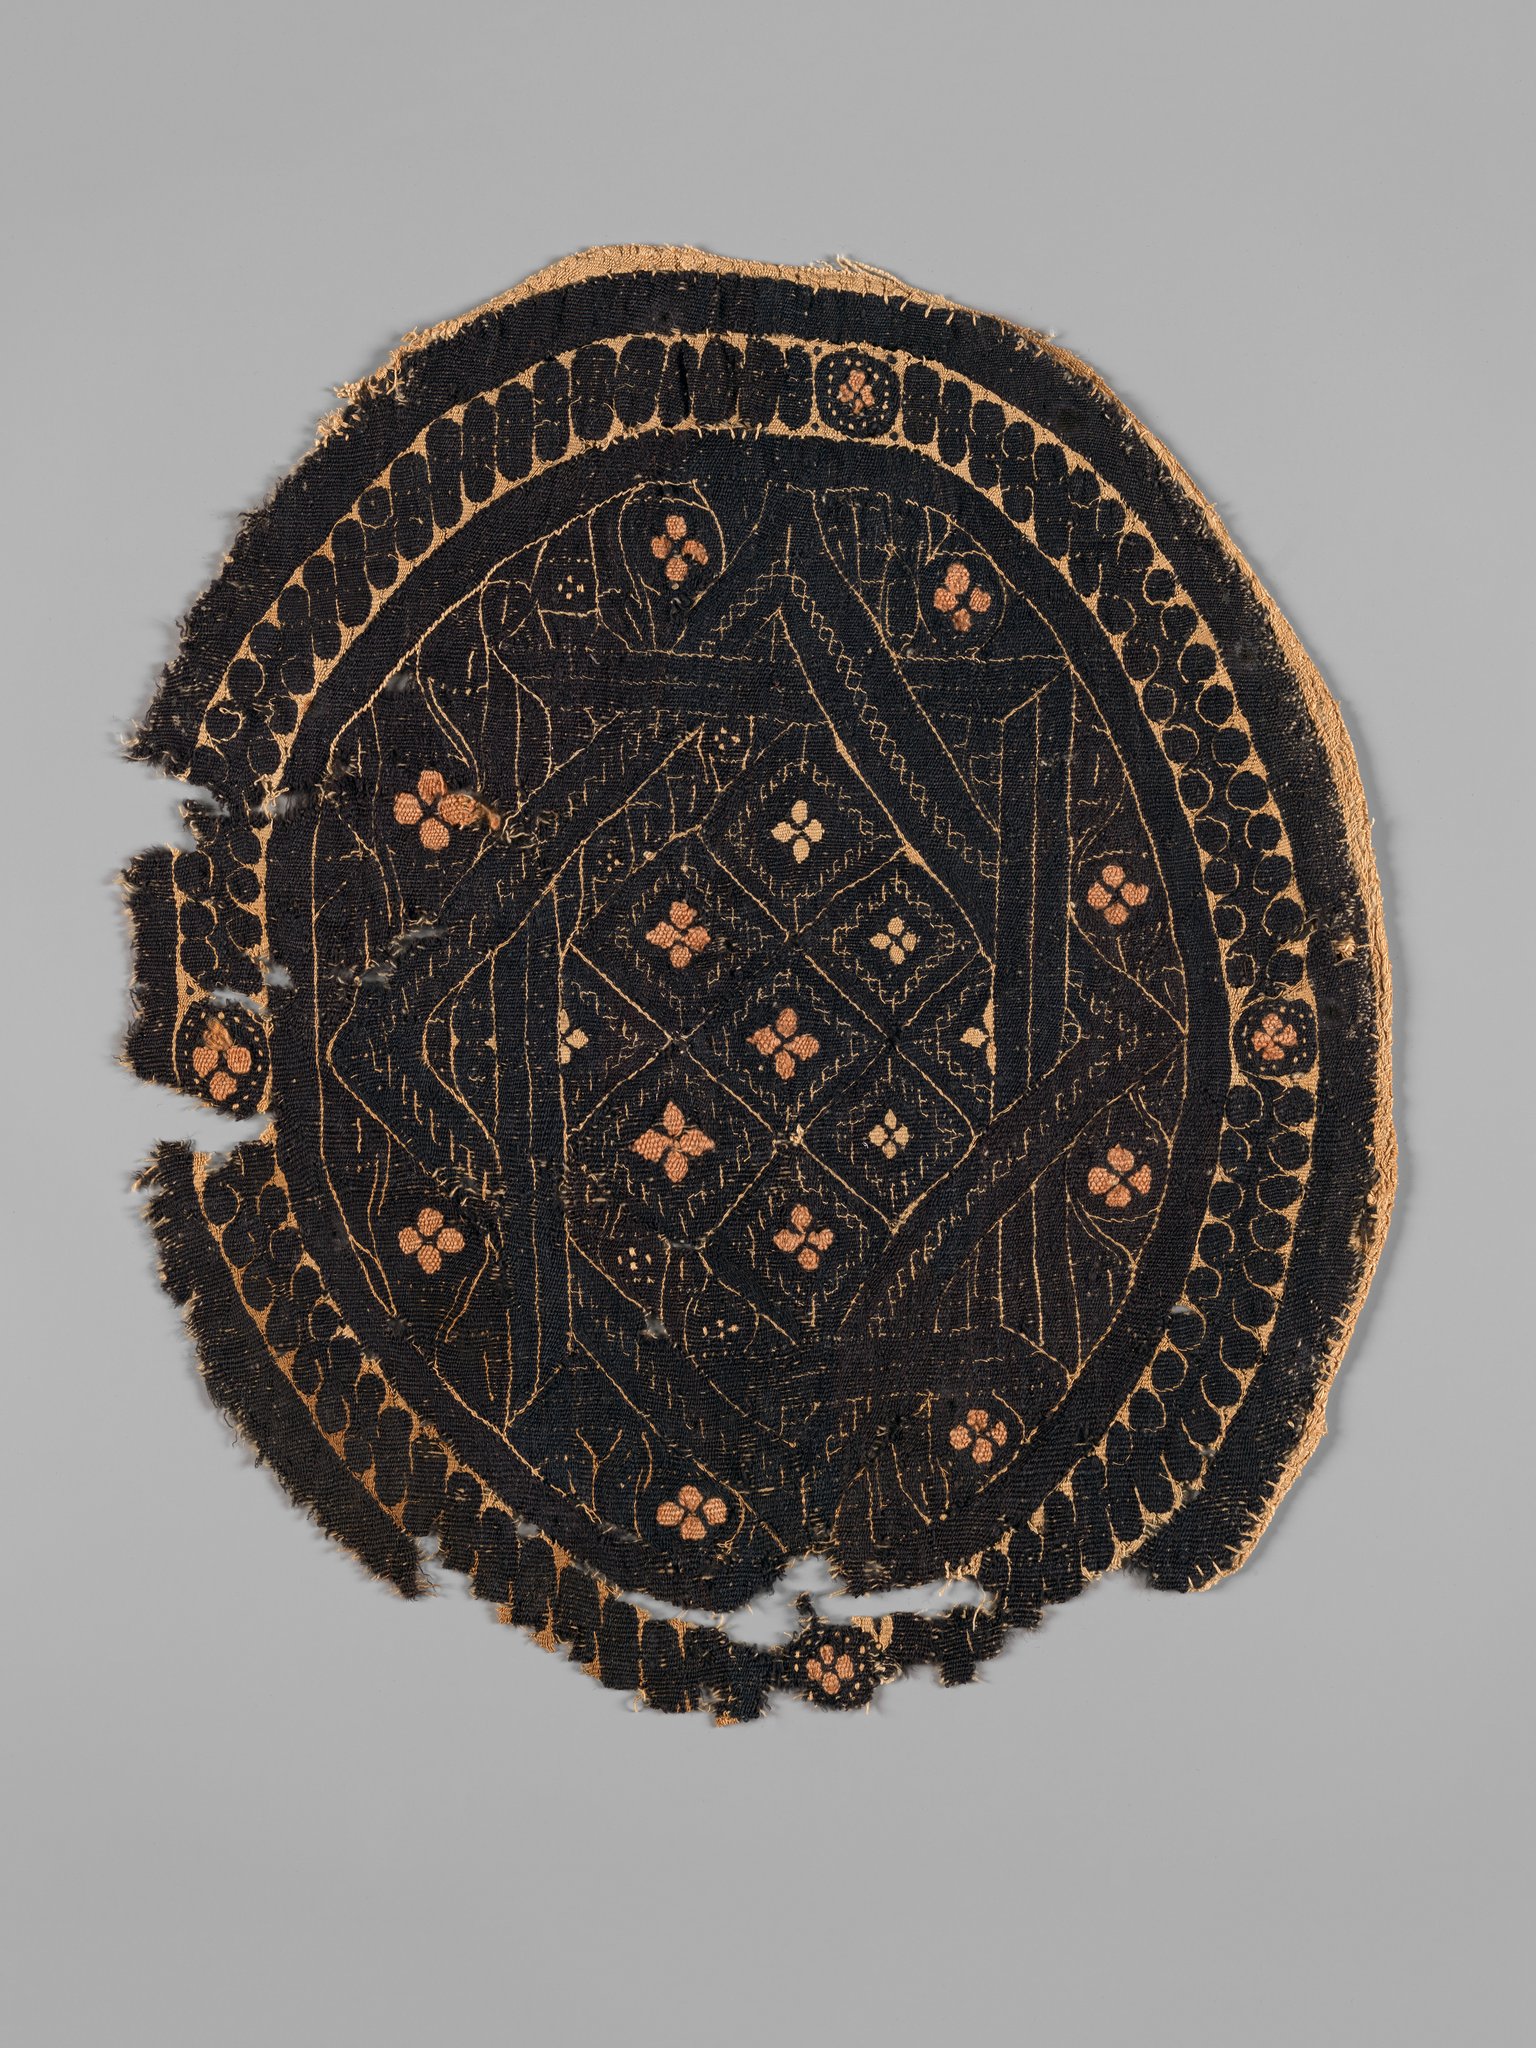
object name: roundel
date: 201-400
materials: linen, wool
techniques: weave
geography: egypt